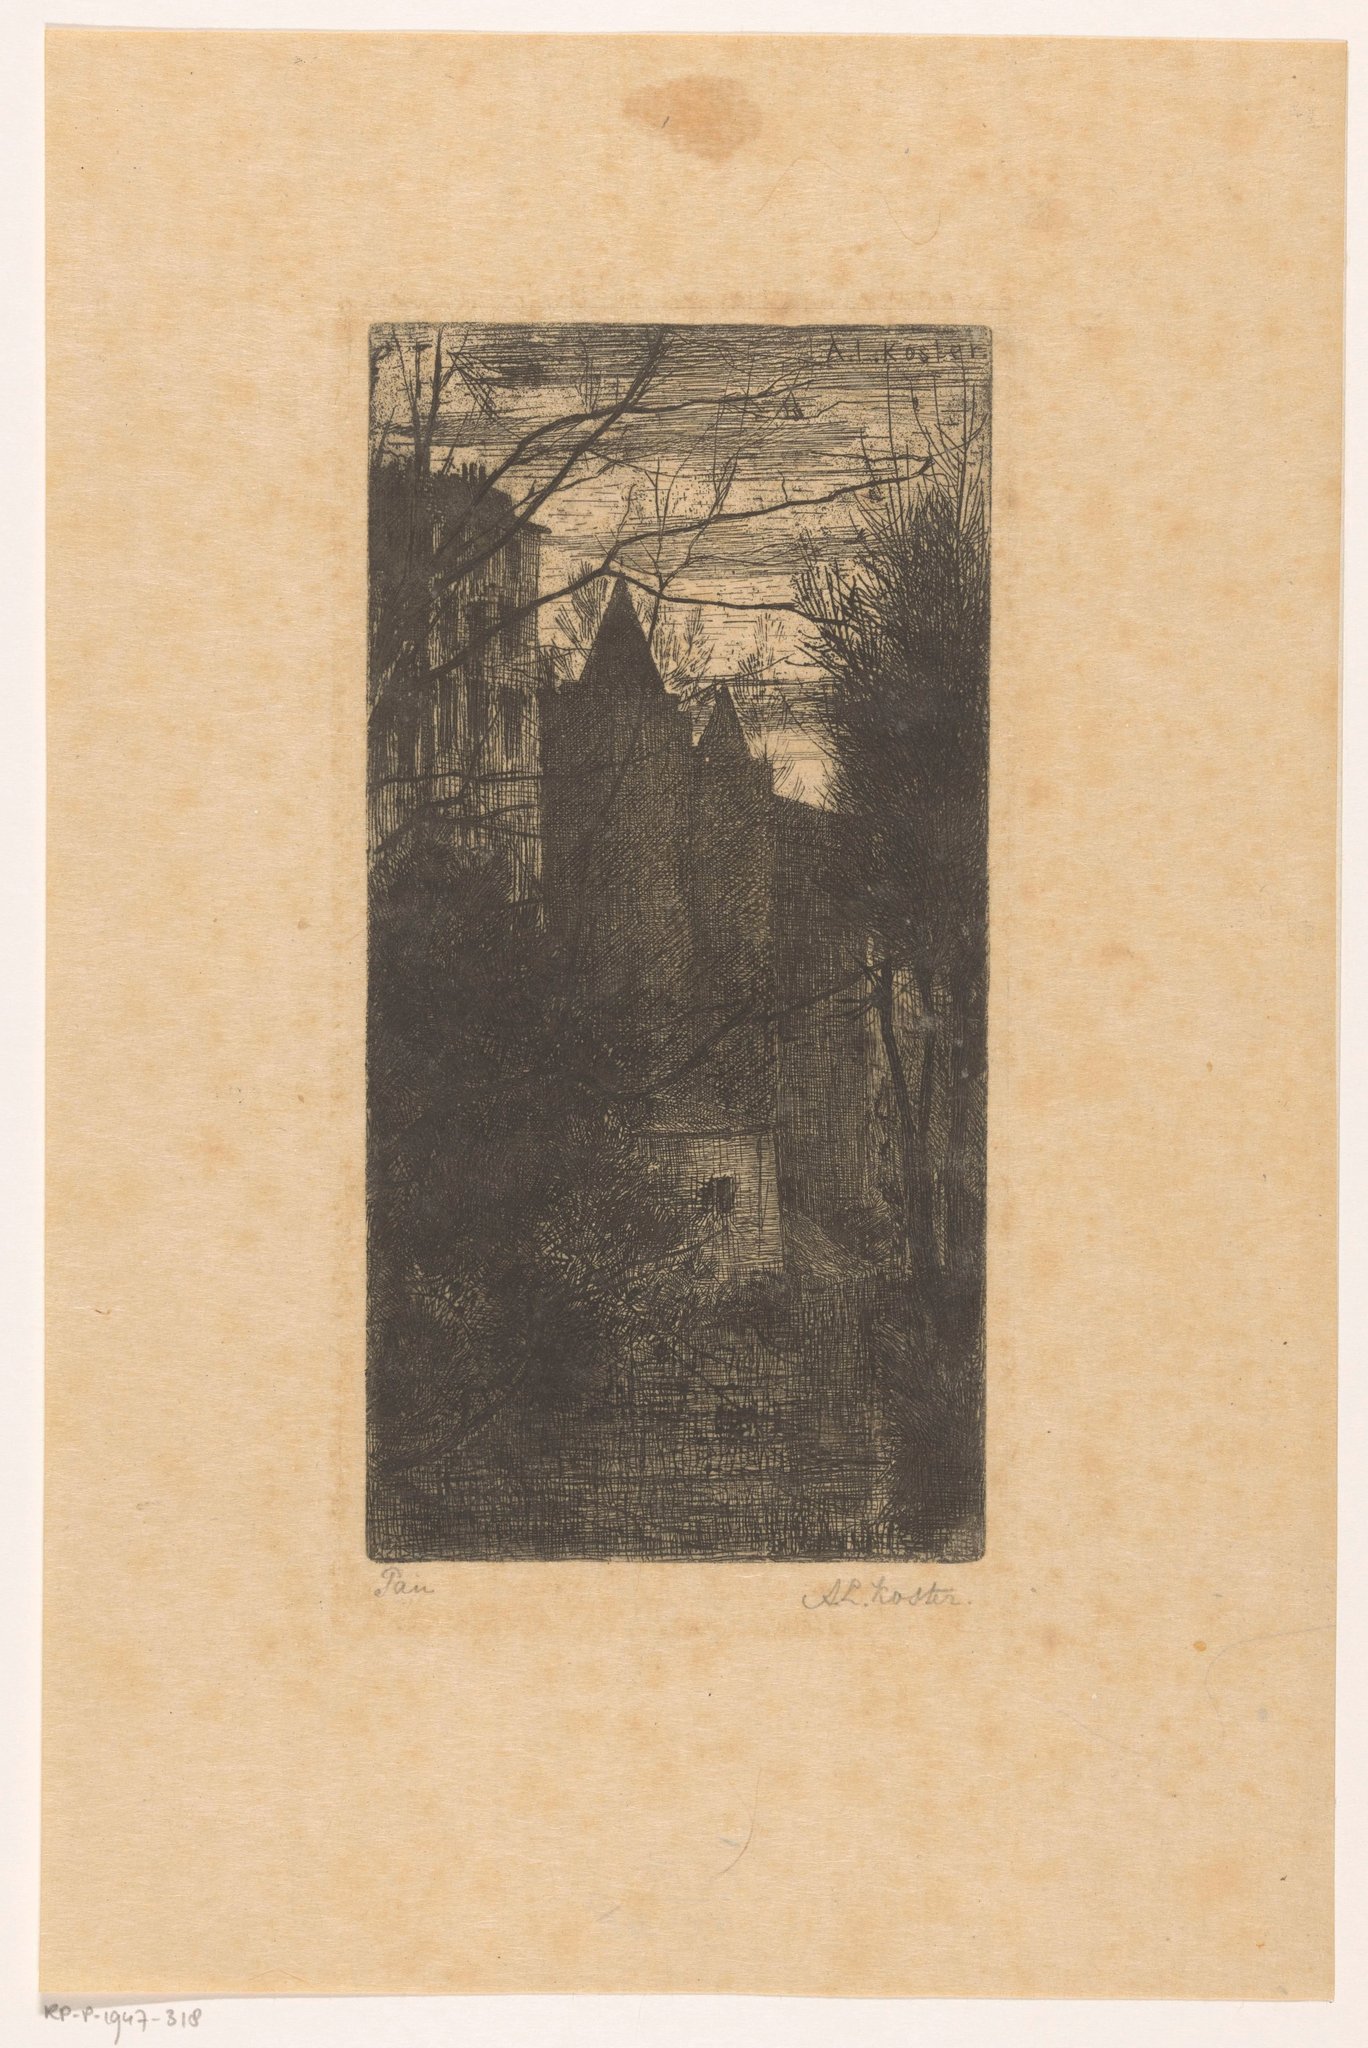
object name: print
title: Kasteel van Pau in de schemering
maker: anton l. koster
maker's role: draughtsman, painter, print maker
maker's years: 1859-1937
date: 1869-1937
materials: paper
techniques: etching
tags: dusk, evening twilight, trees (+ bare plant), landscape with tower or castle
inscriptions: collector's mark: Lugt 2228